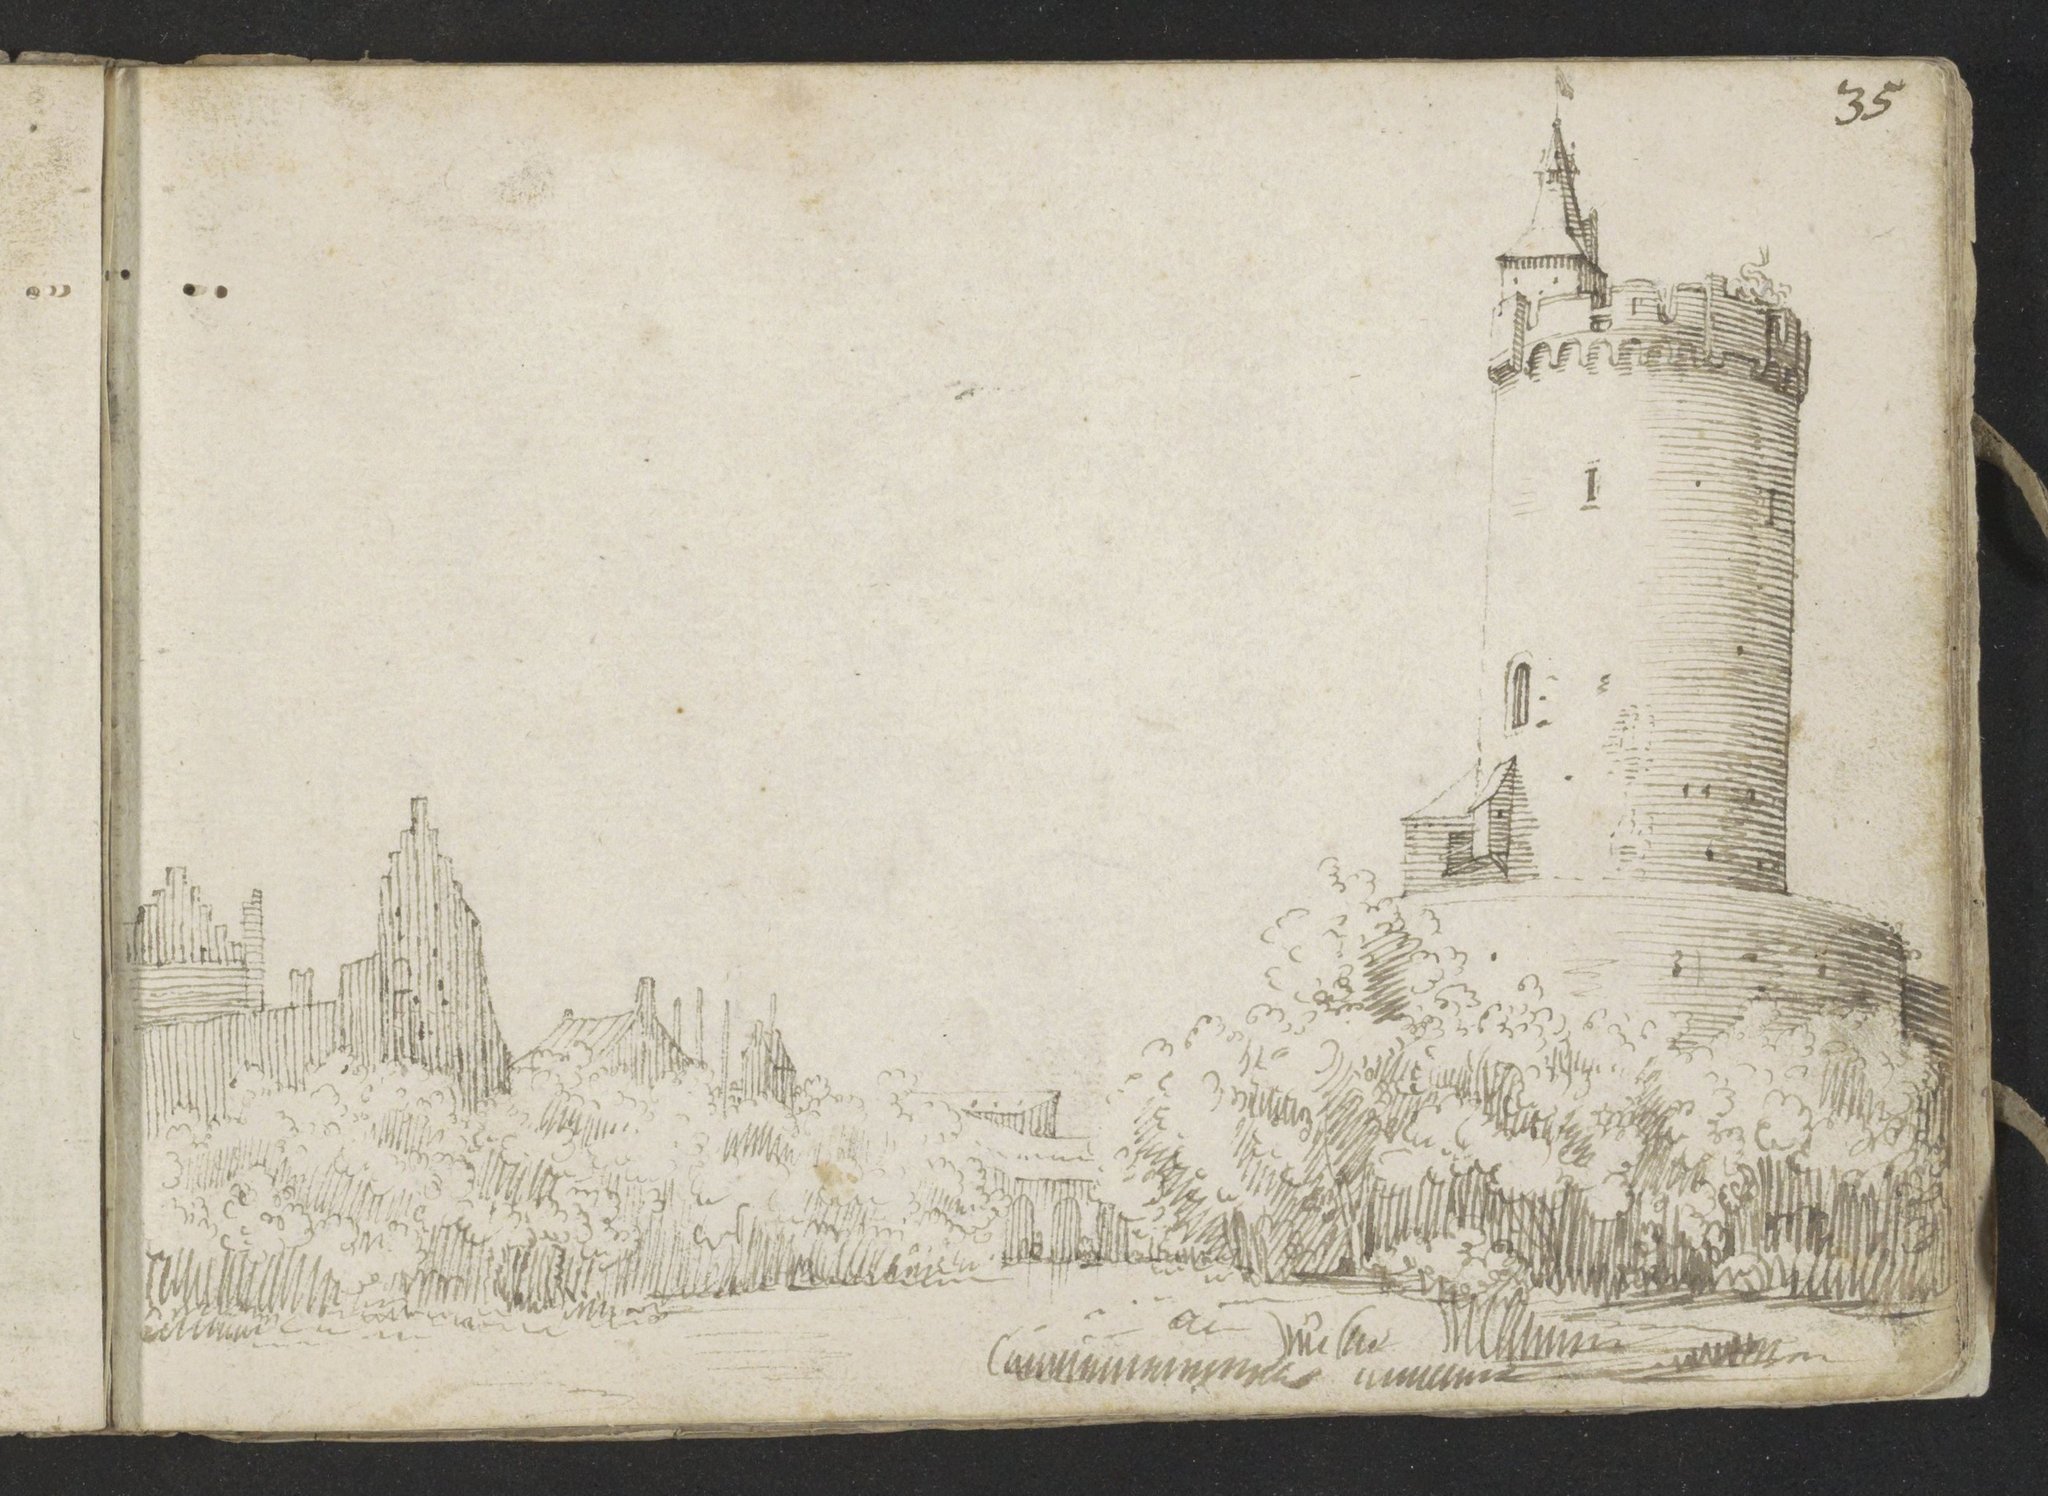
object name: sketchbook leaf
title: Toren in een landschap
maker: gerard ter borch (ii)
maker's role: draughtsman, painter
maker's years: 1617-1681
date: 1631-1633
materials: ink, paper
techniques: pen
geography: zwolle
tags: towers ~ fortified city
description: Blad 35 recto uit een schetsboek met 55 bladen.